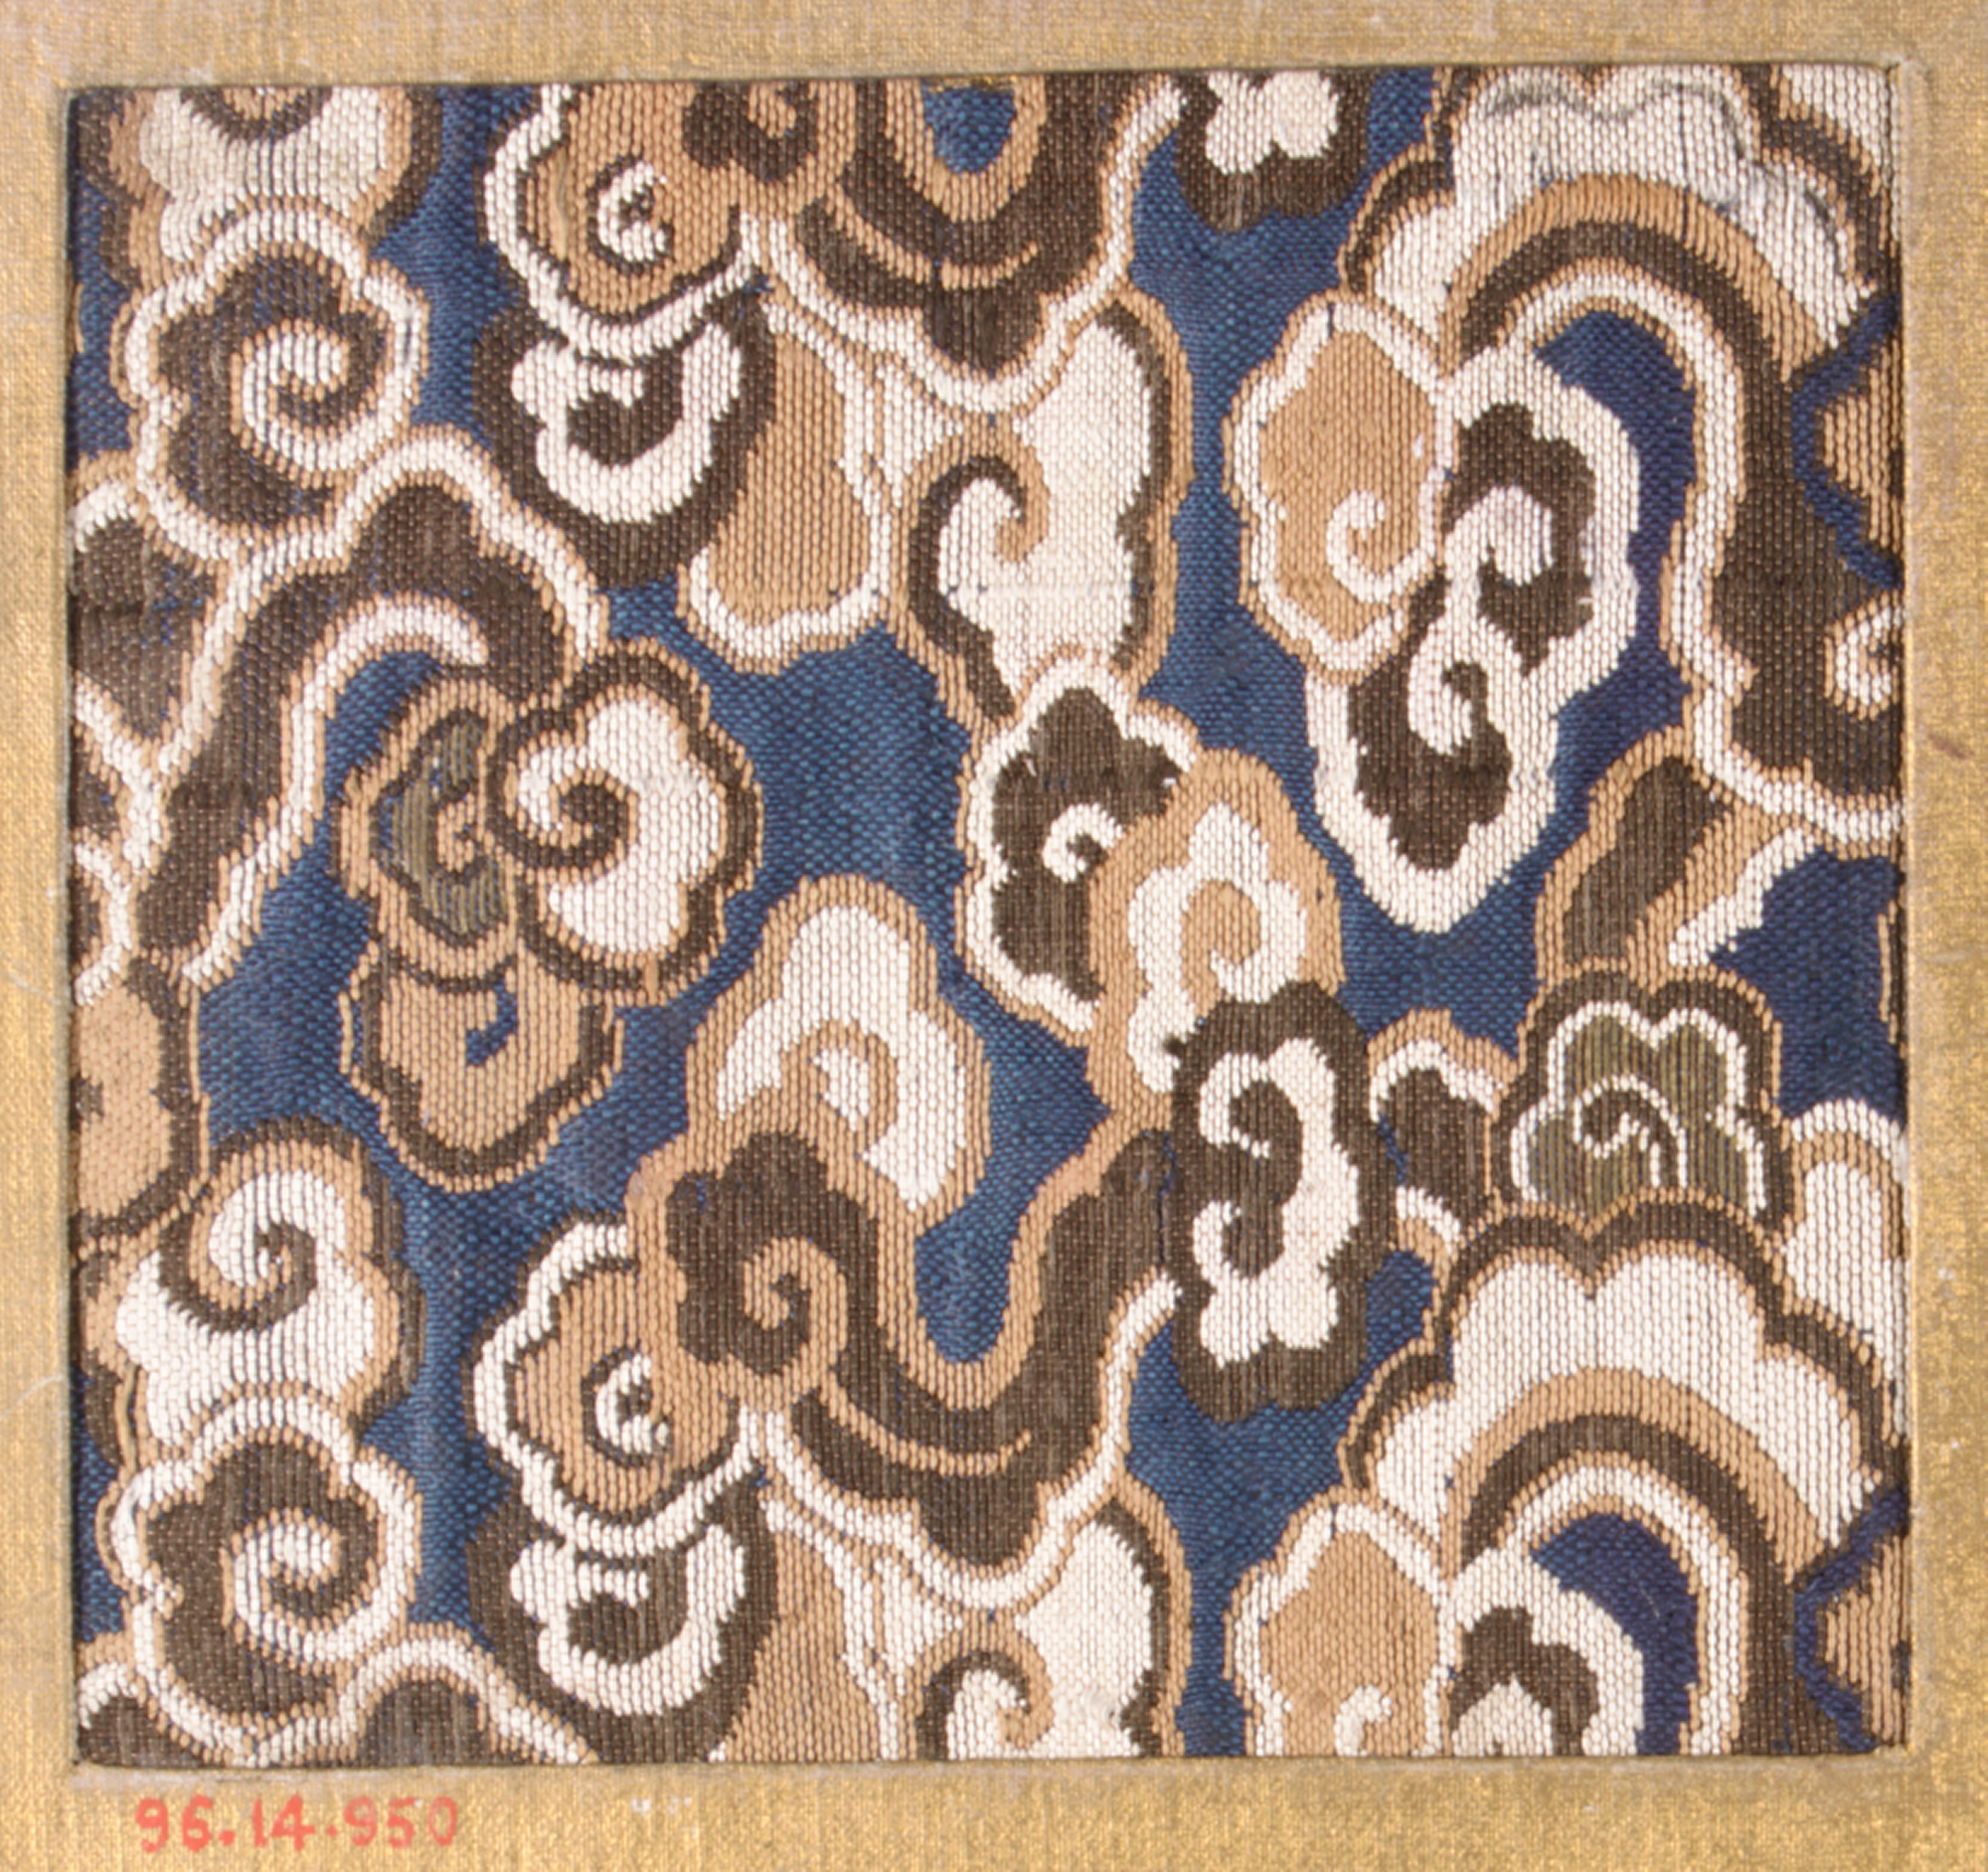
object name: piece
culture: japanese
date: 1701-1900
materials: silk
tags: clouds